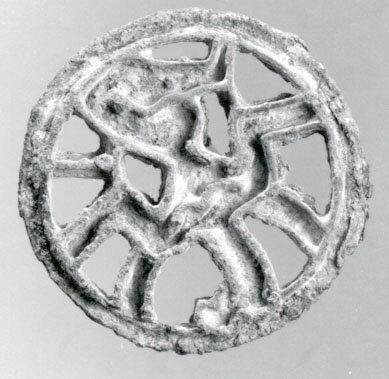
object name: stamp seal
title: Openwork stamp seal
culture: bactria-margiana archaeological complex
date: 2333-1668 BCE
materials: copper alloy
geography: bactria-margiana